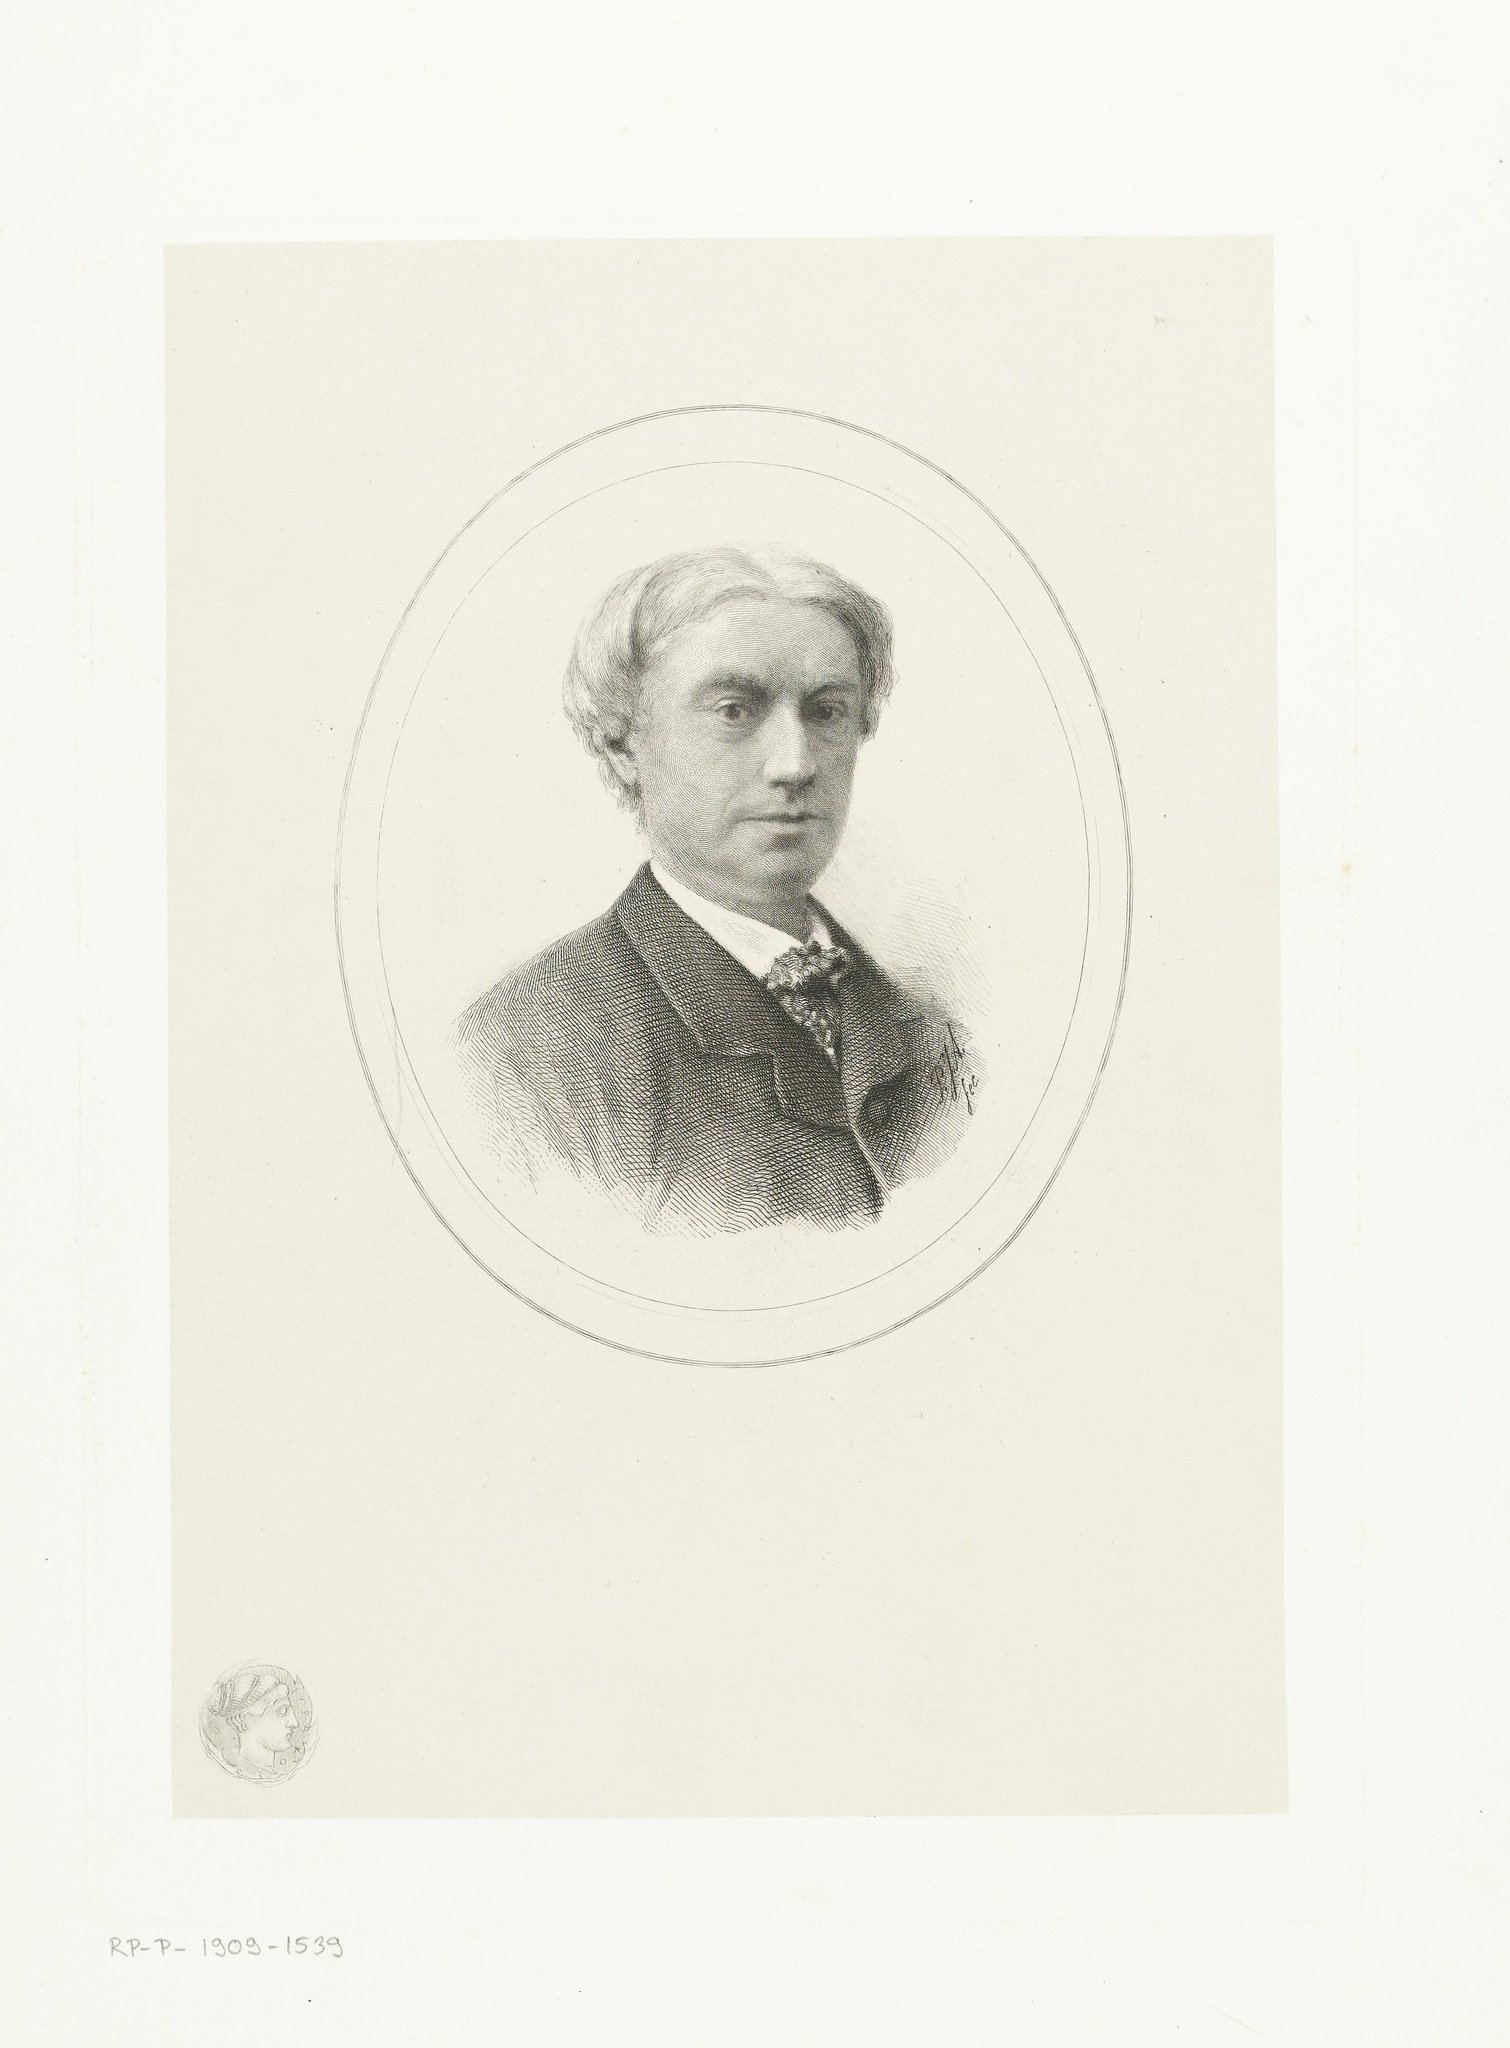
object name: print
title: Portret van Carel Vosmaer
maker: petrus johannes arendzen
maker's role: draughtsman, print maker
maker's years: 1846-1932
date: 1856-1885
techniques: printmaking, engraving, etching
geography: netherlands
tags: the hague, draughtsman, carel vosmaer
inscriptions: collector's mark: Lugt 2228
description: Portret van Carel Vosmaer. In marge een medaille met het hoofd van een Griekse vrouw.